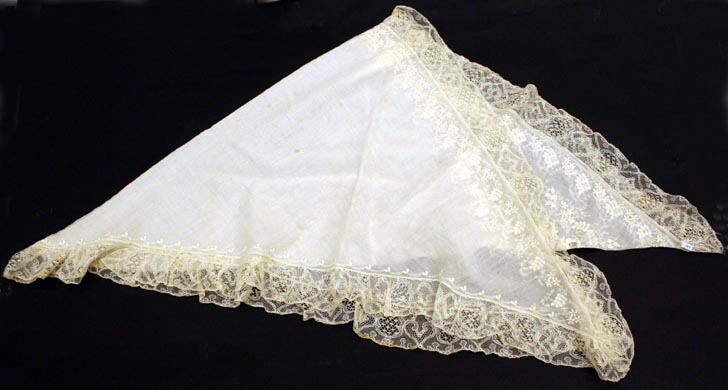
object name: fichu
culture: british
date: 1770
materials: cotton